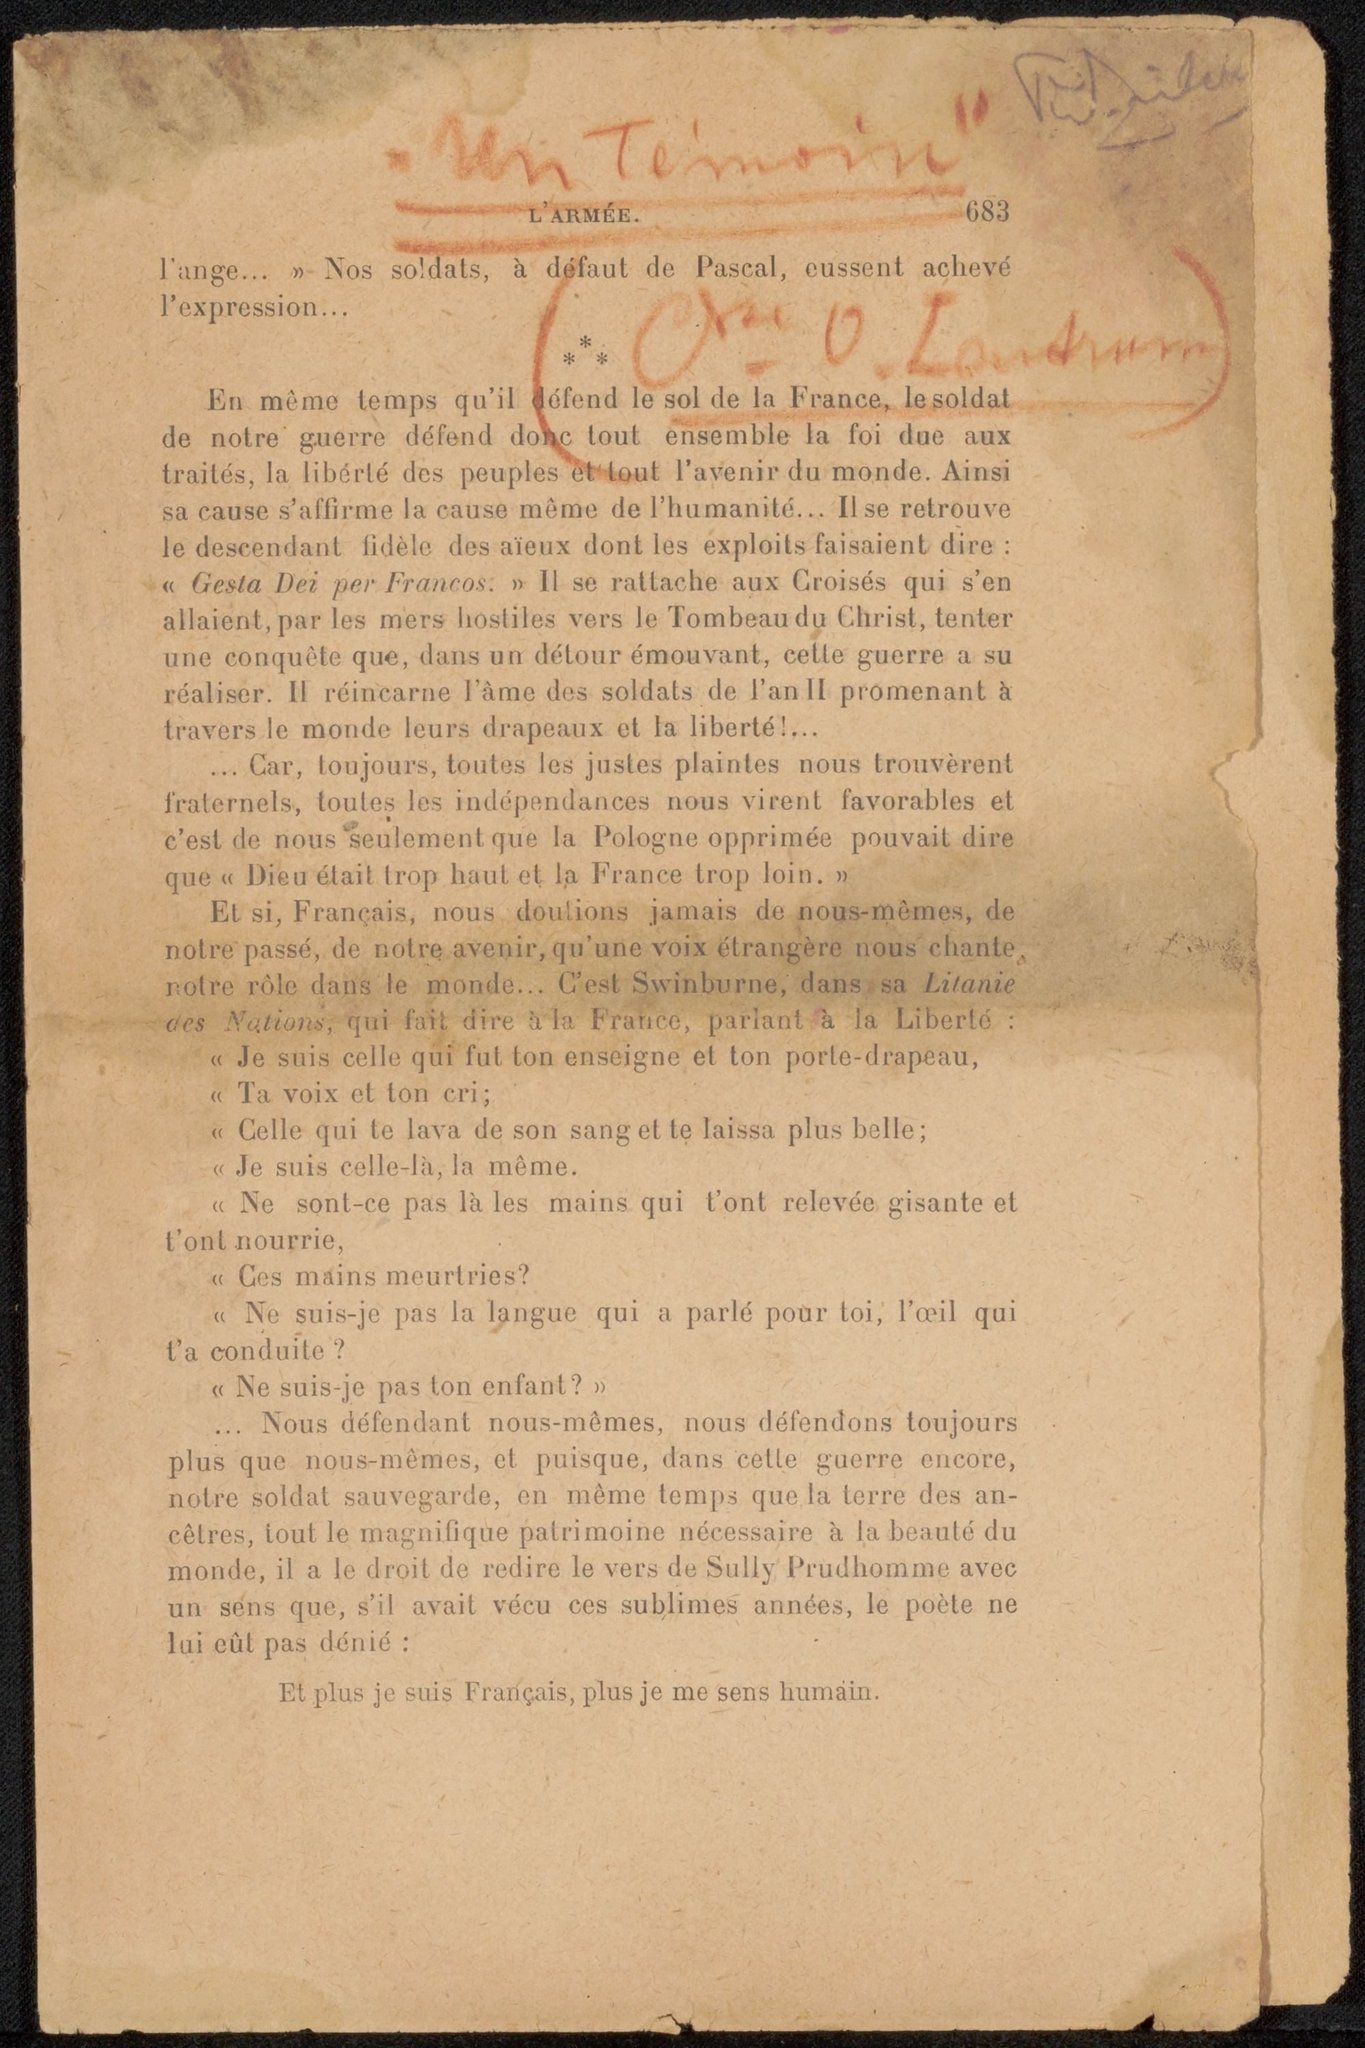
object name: article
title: Artikel uit archief Philip Zilcken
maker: firmin roz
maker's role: criticus, essayist, historicus, leraar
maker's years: 1866-1957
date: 1918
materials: paper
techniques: printing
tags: gravin olga leutrum von ertingen-okolicsanyi d’okolica, the hague, painter, draughtsman, philip zilcken